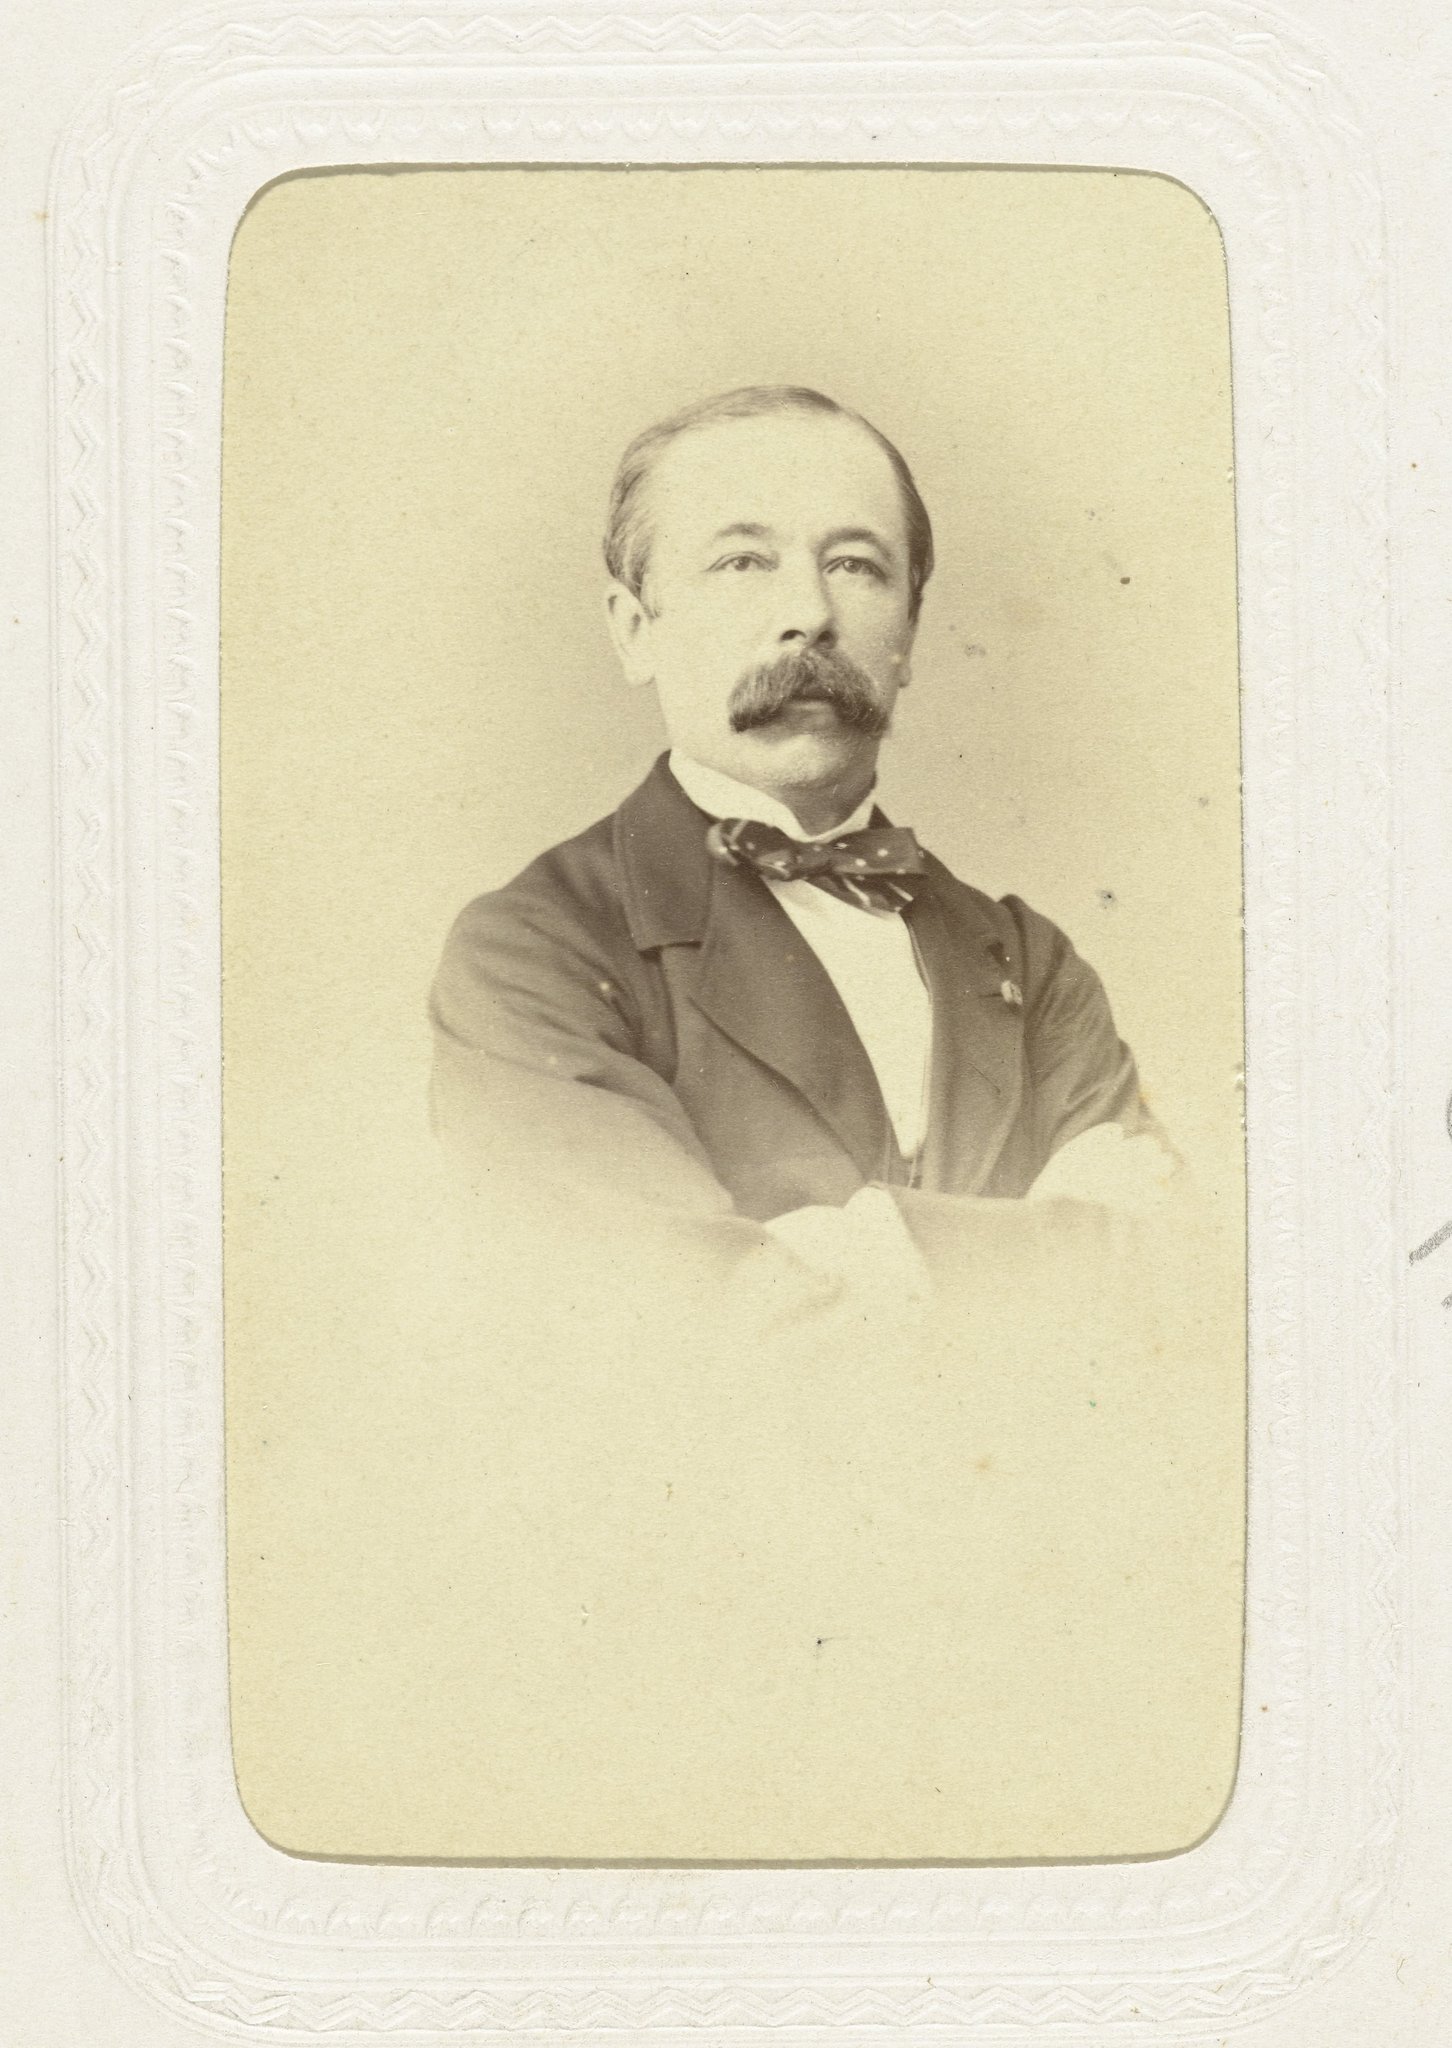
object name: carte de visite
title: Studioportret van een man met een snor, gekleed in een donker pak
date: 1863-1866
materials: cardboard, paper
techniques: albumen print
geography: istanbul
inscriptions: name: ‘Abdullah freres, Constantinople’, name: ‘Lallemant’